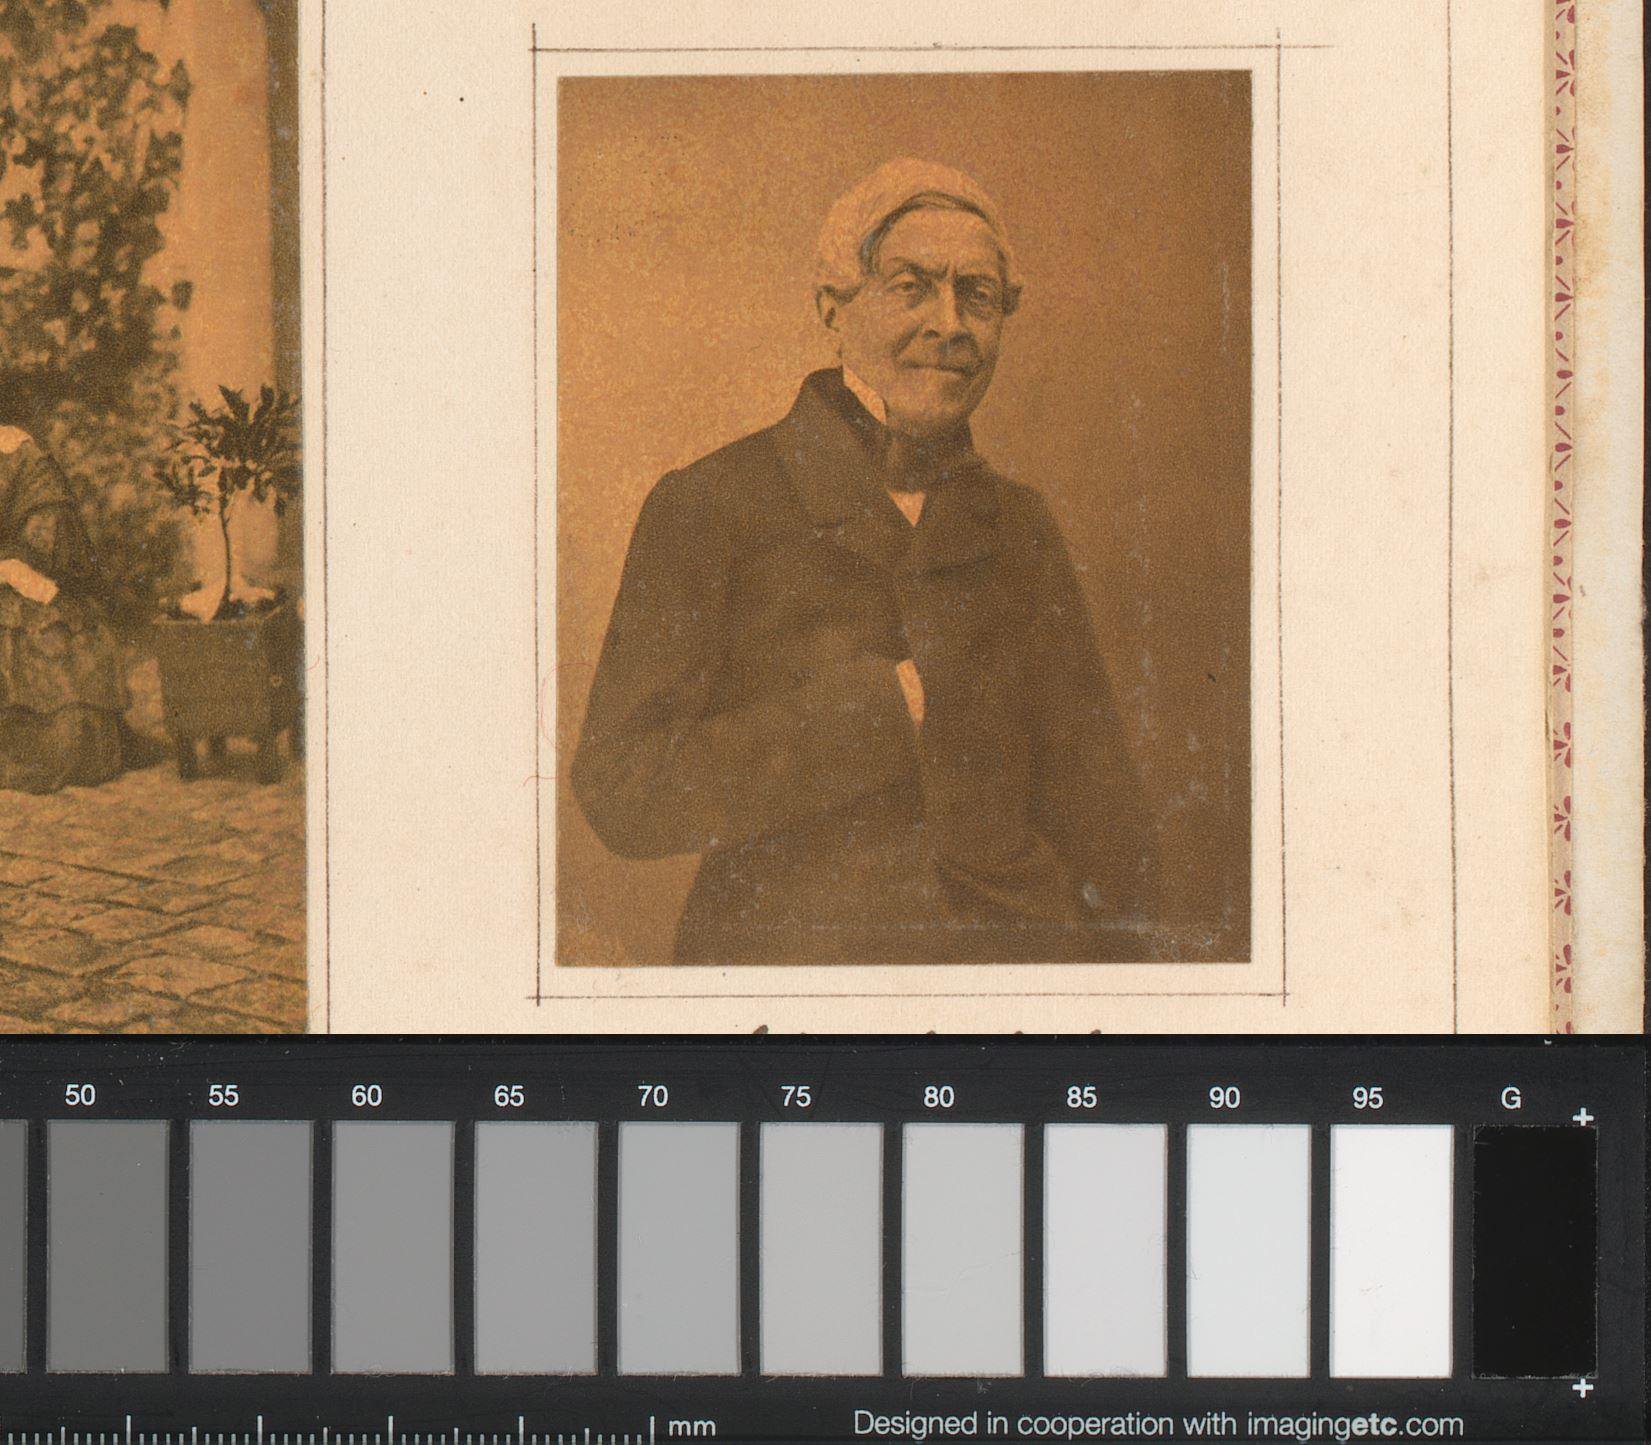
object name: album leaf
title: Michelet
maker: Anonymous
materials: paper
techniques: rotogravure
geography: france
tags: paris, writer, poet, author, france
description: Deze prent maakt deel uit van een album.